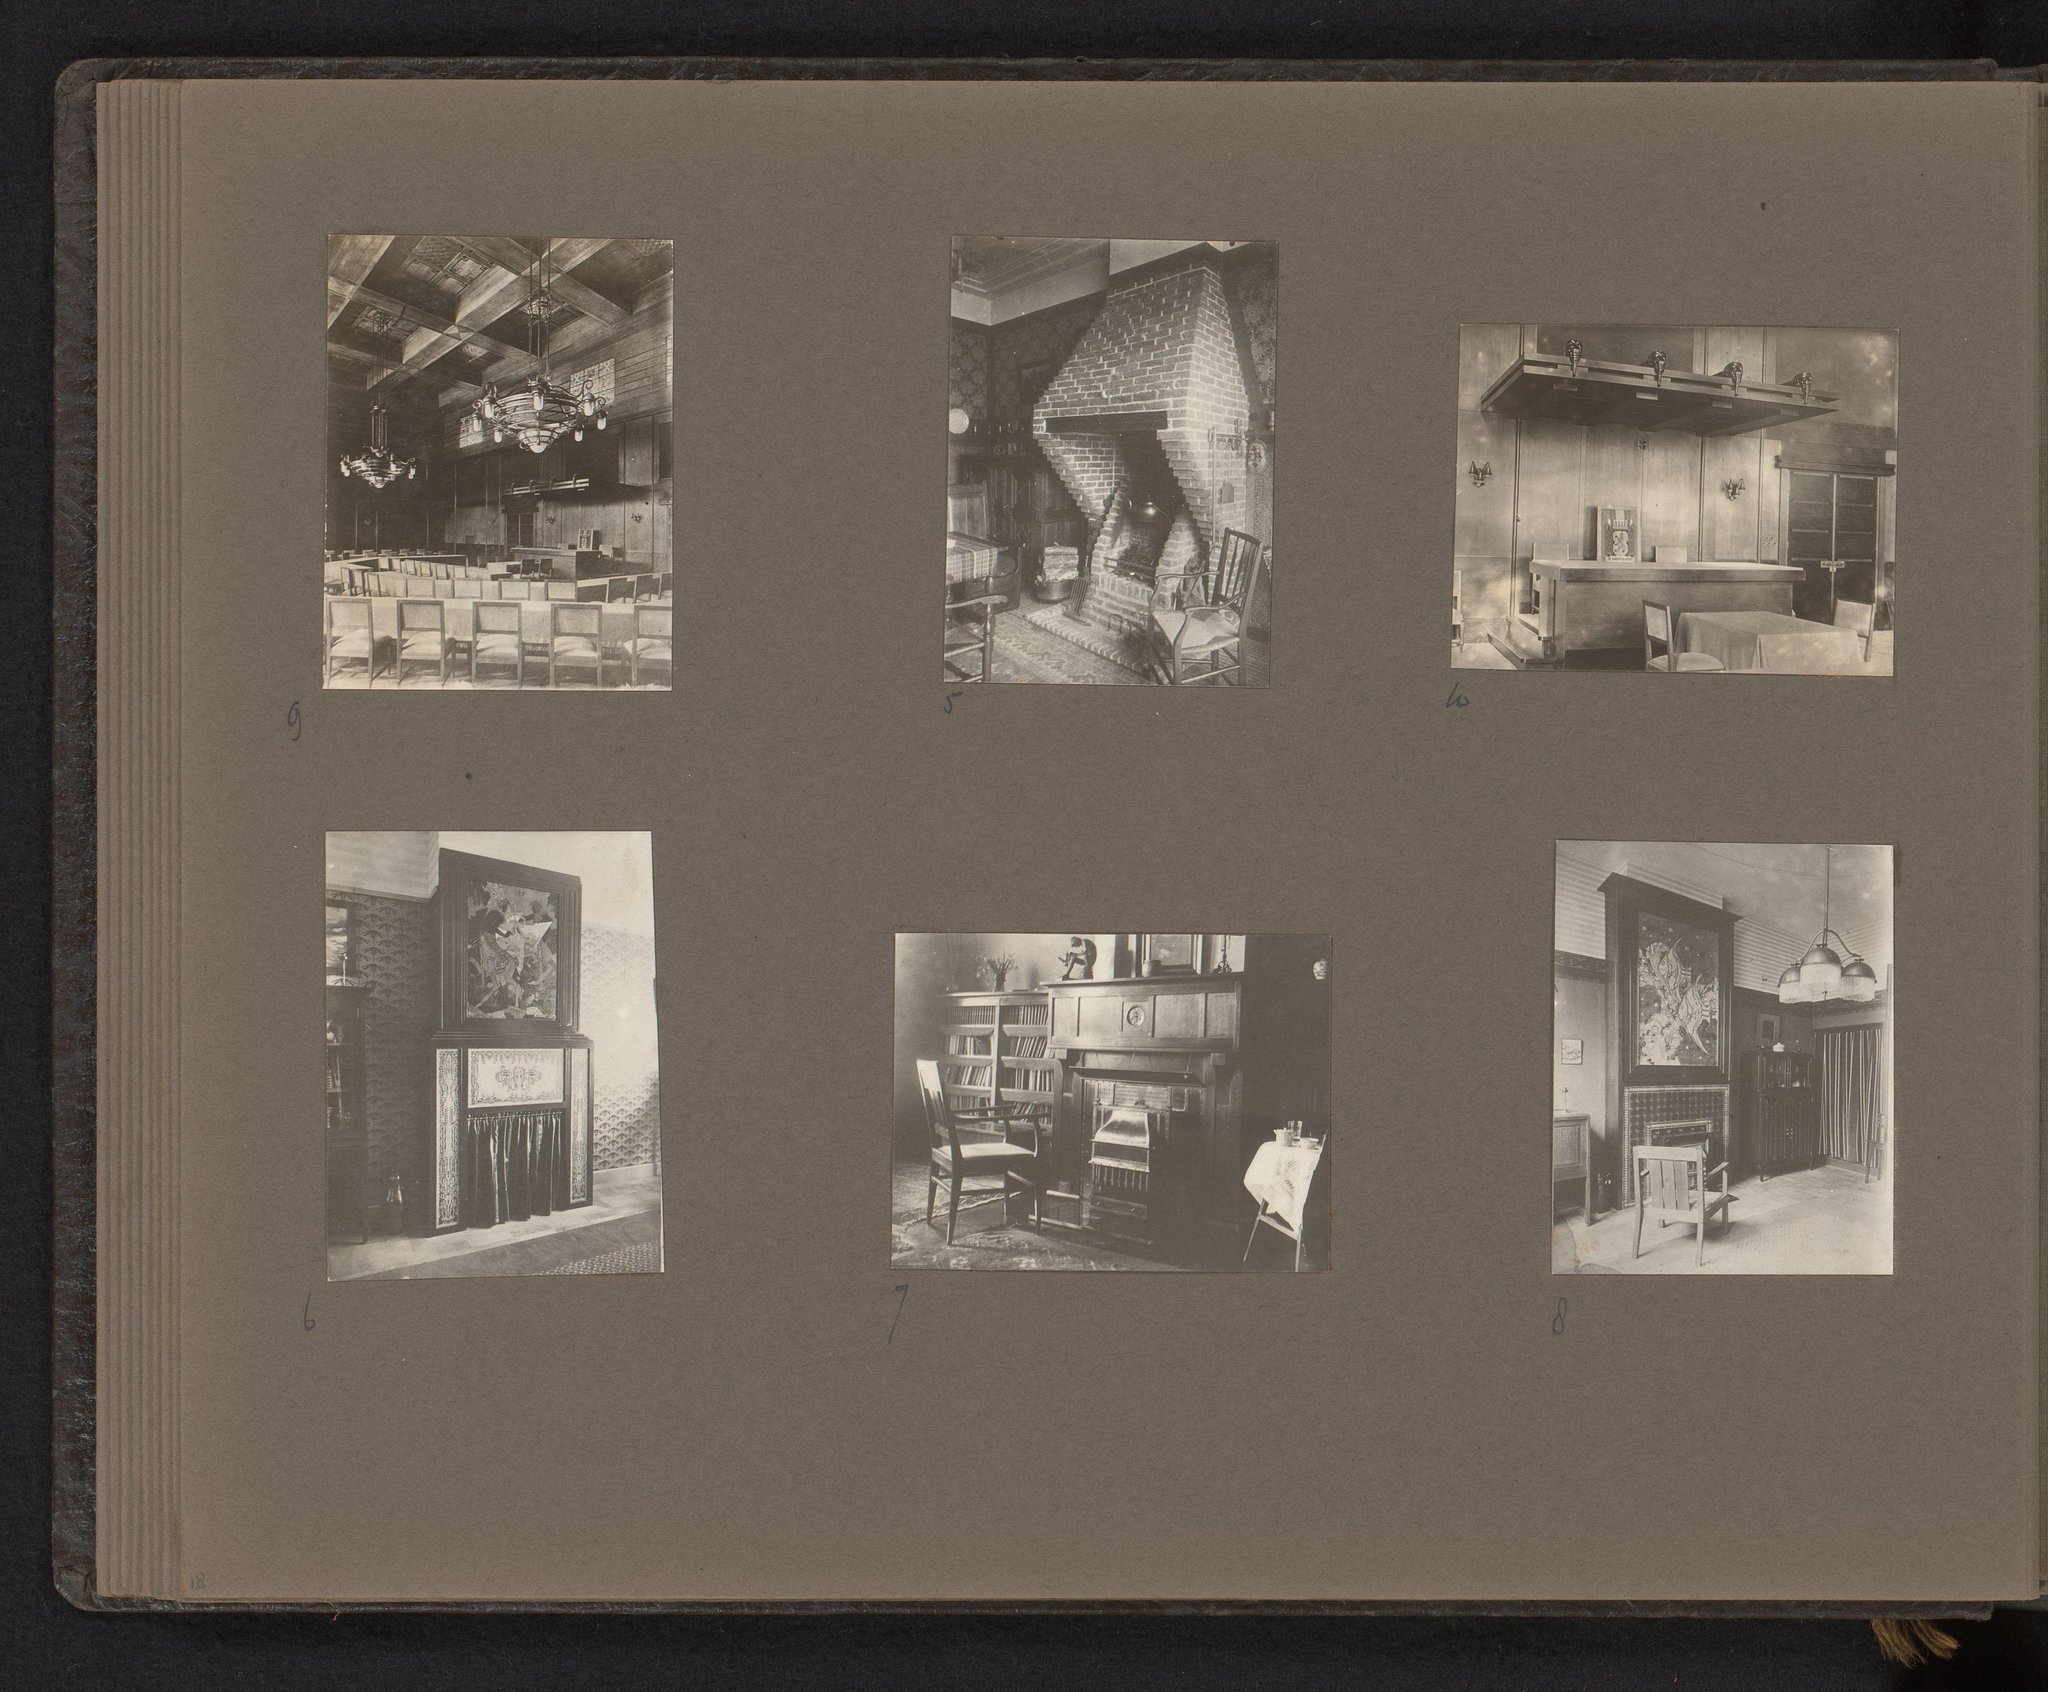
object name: photograph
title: Zes interieurs, waarvan vier met schoorsteenmantel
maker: Anonymous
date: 1920-1940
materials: paper, photographic support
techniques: gelatin silver print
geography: netherlands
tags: assembly-room, chimney-piece, mantelpiece, living-room, parlour, sitting-room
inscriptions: number: ‘9 - 5 - 10/ 6 - 7 - 8’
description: Deze foto's maken deel uit van een album.